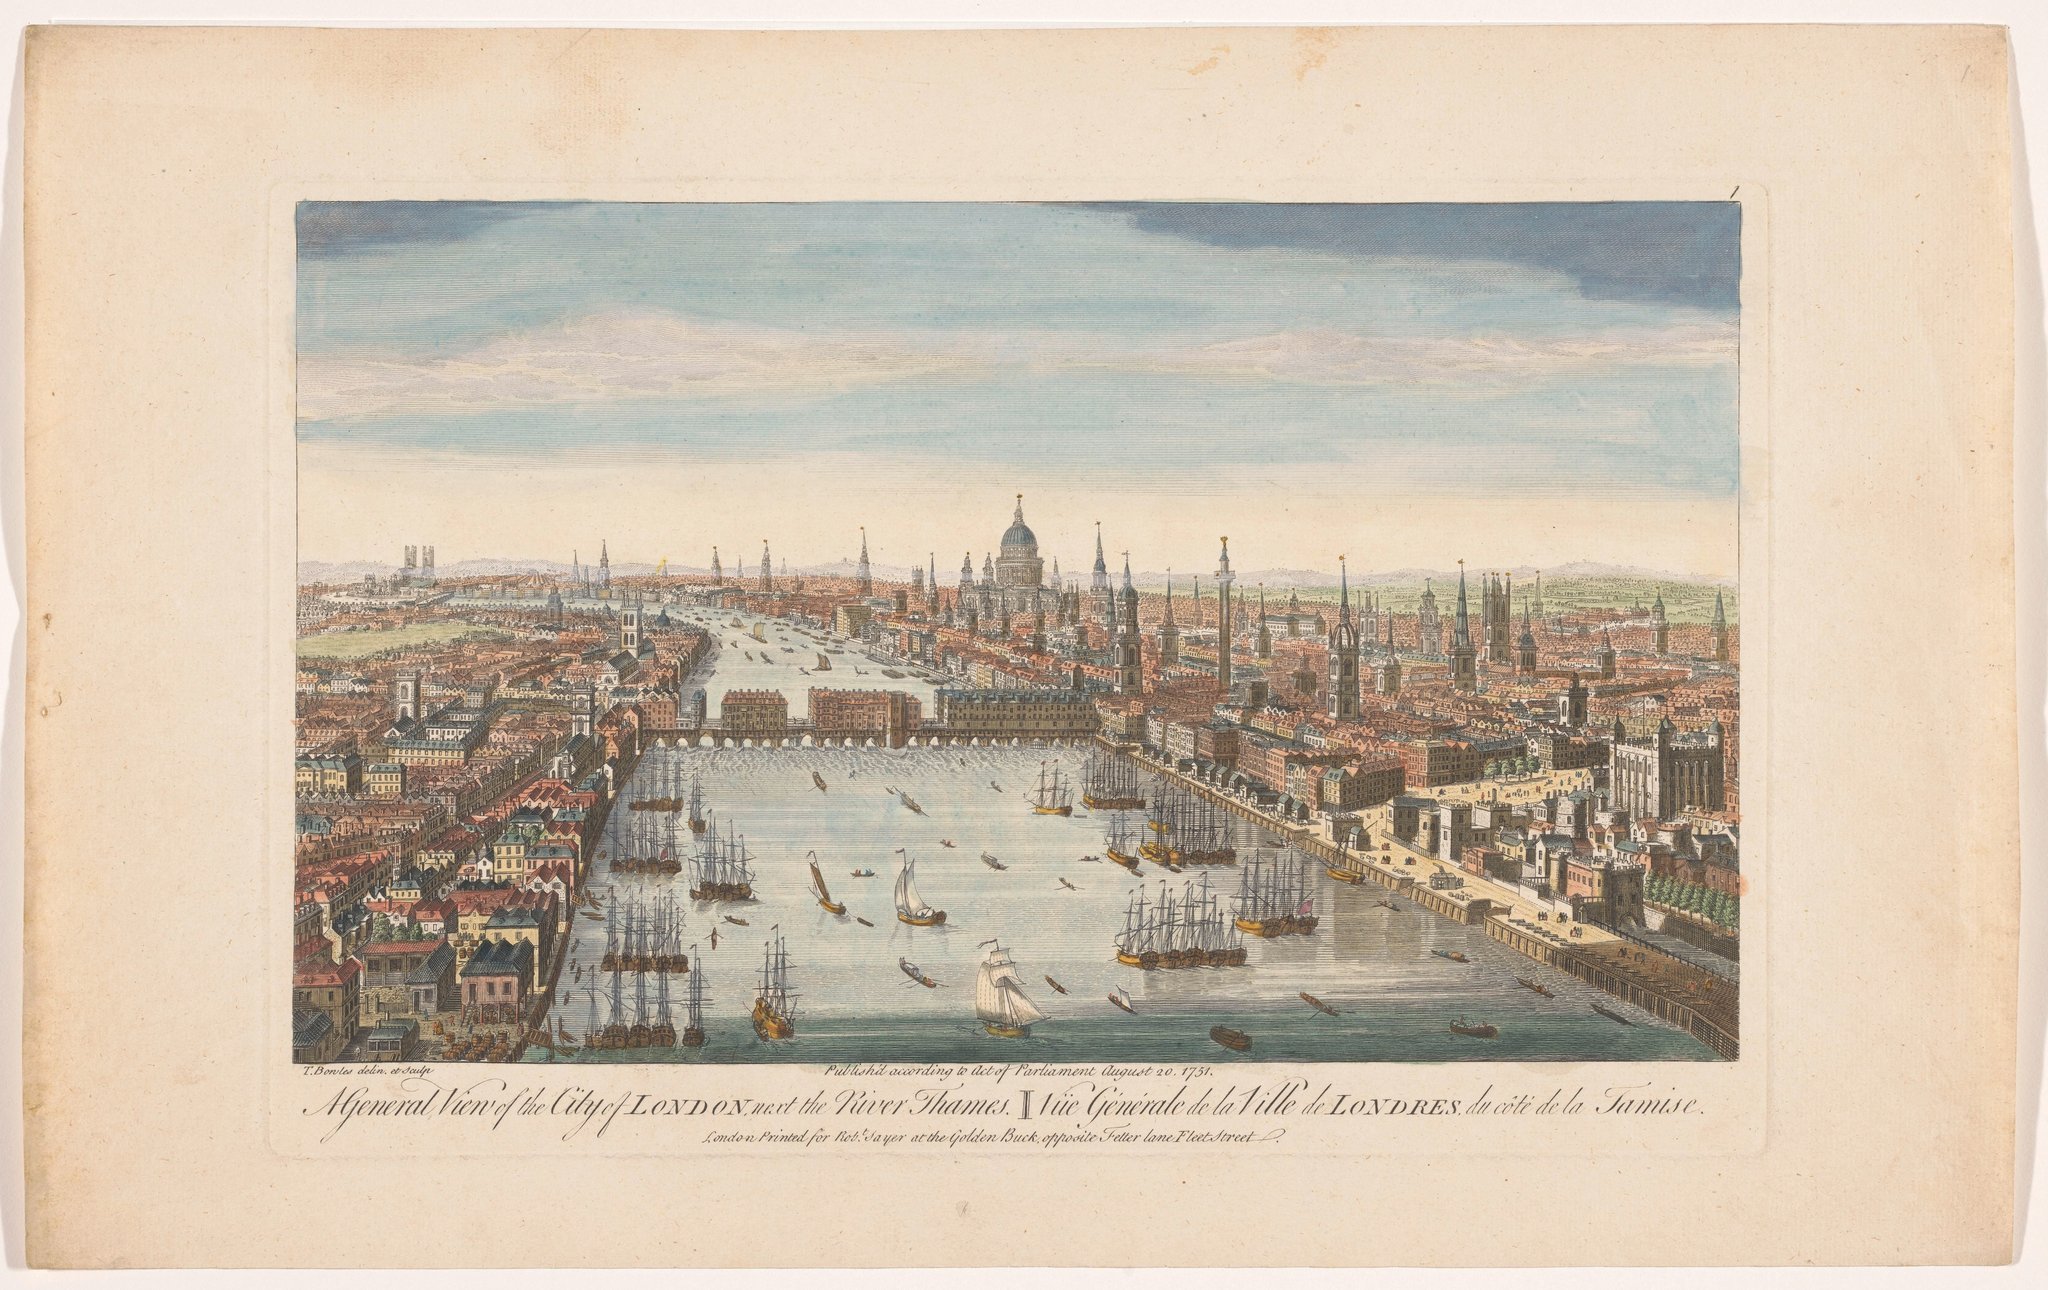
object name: opticaprent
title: A general view of the city of London, next the river Thames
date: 1751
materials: paper, watercolor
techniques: brush, etching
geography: london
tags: bridge in city across river, canal, etc. (+ city(-scape) with figures, staffage), sailing-ship, sailing-boat, church (exterior), city-view in general; 'veduta' (+ city(-scape) with figures, staffage), westminster abbey, london, thames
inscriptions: watermark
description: In het midden een bebouwde brug over de rivier de Theems en Saint Paul's Cathedral. Op de achtergrond links Westminster Abbey. Rechtsboven genummerd: 1.